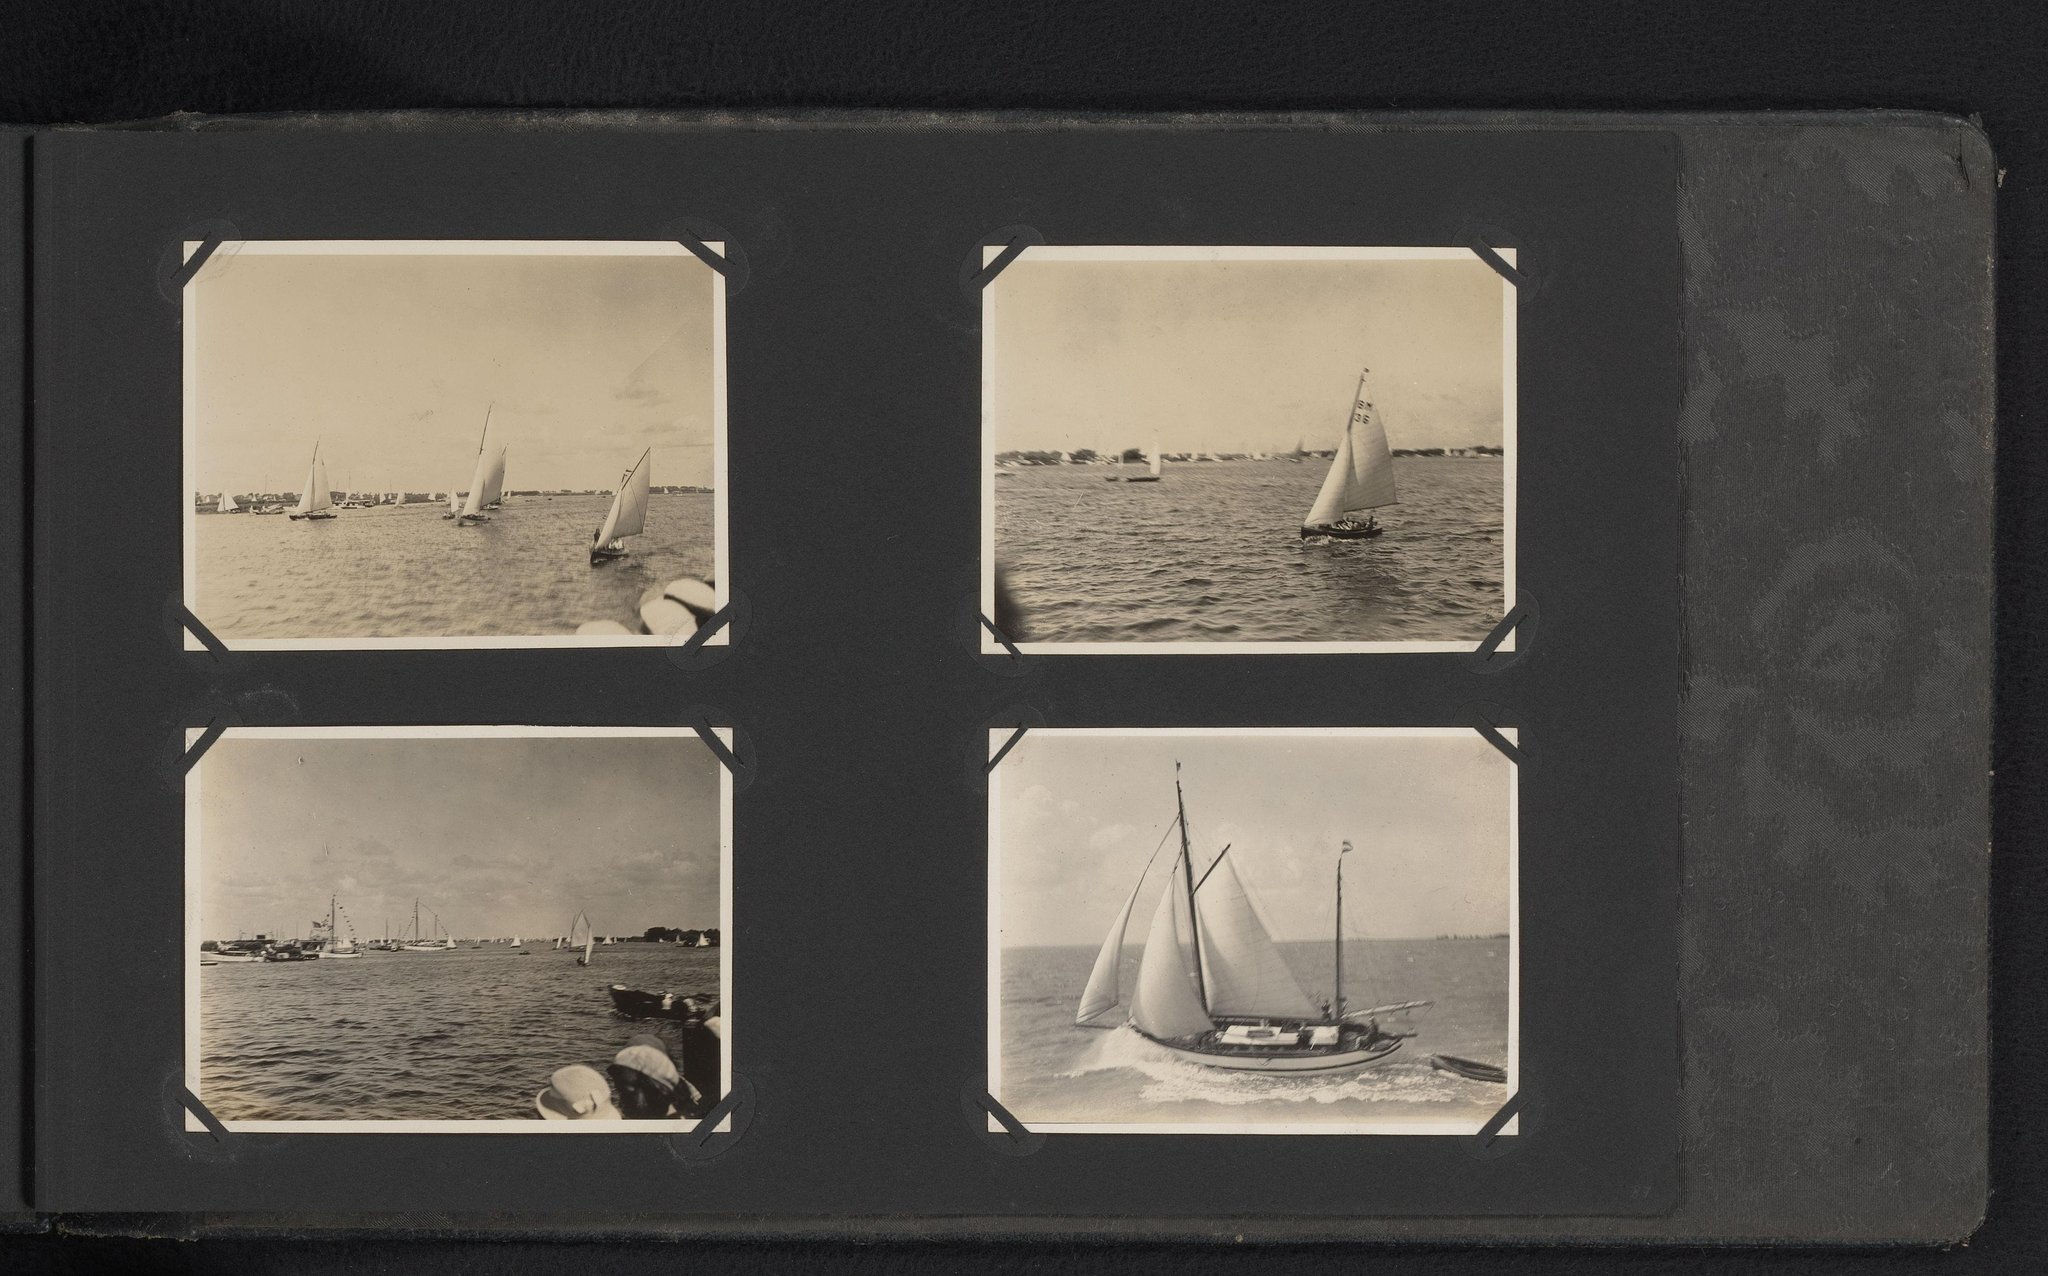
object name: photograph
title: Vier foto's van zeilboten op een meer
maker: hendrik herman van den berg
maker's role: amateurfotograaf, jurist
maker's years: 1875-1944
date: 1932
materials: paper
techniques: gelatin silver print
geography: netherlands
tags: sailing-ship, sailing-boat, netherlands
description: Deze foto's maken deel uit van een album.